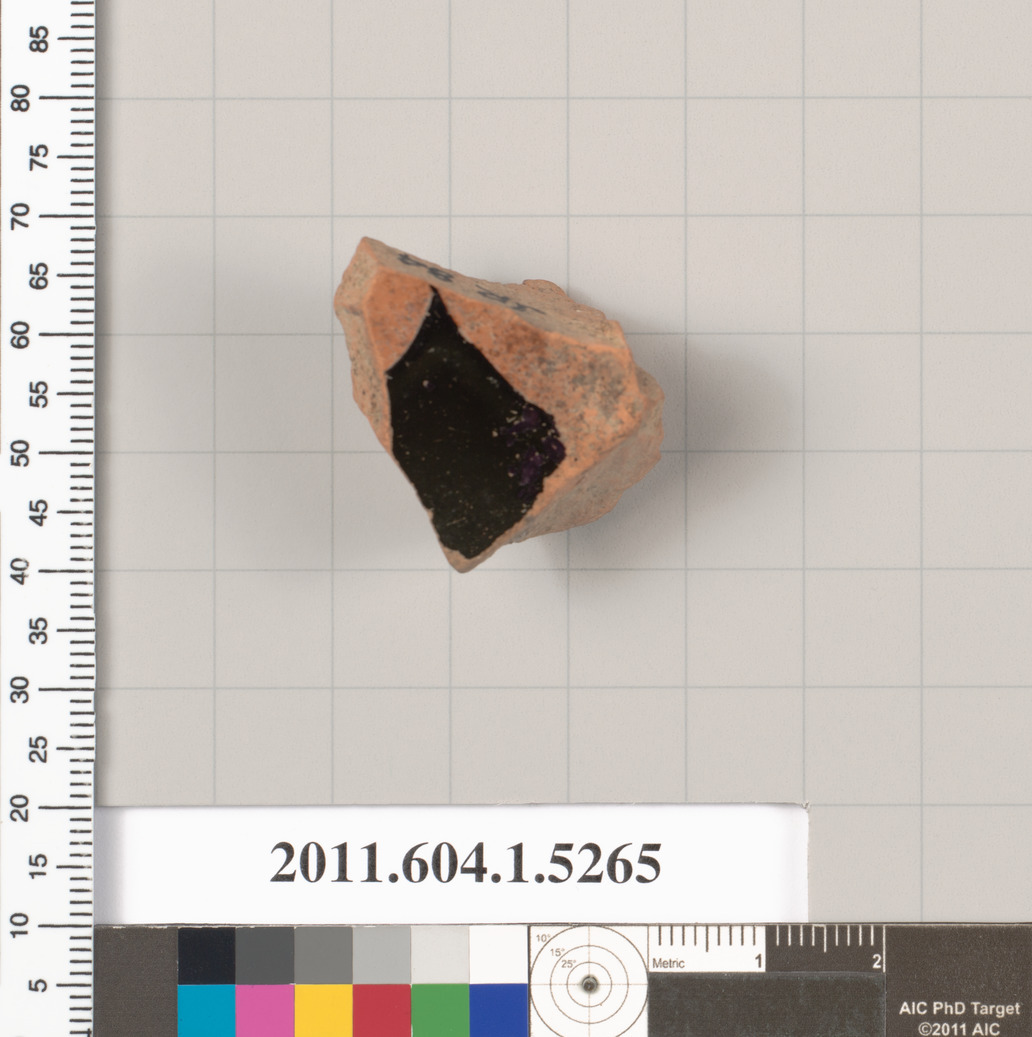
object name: kylix fragment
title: Terracotta fragment of a kylix (drinking cup)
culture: greek, attic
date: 534-468 BCE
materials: terracotta